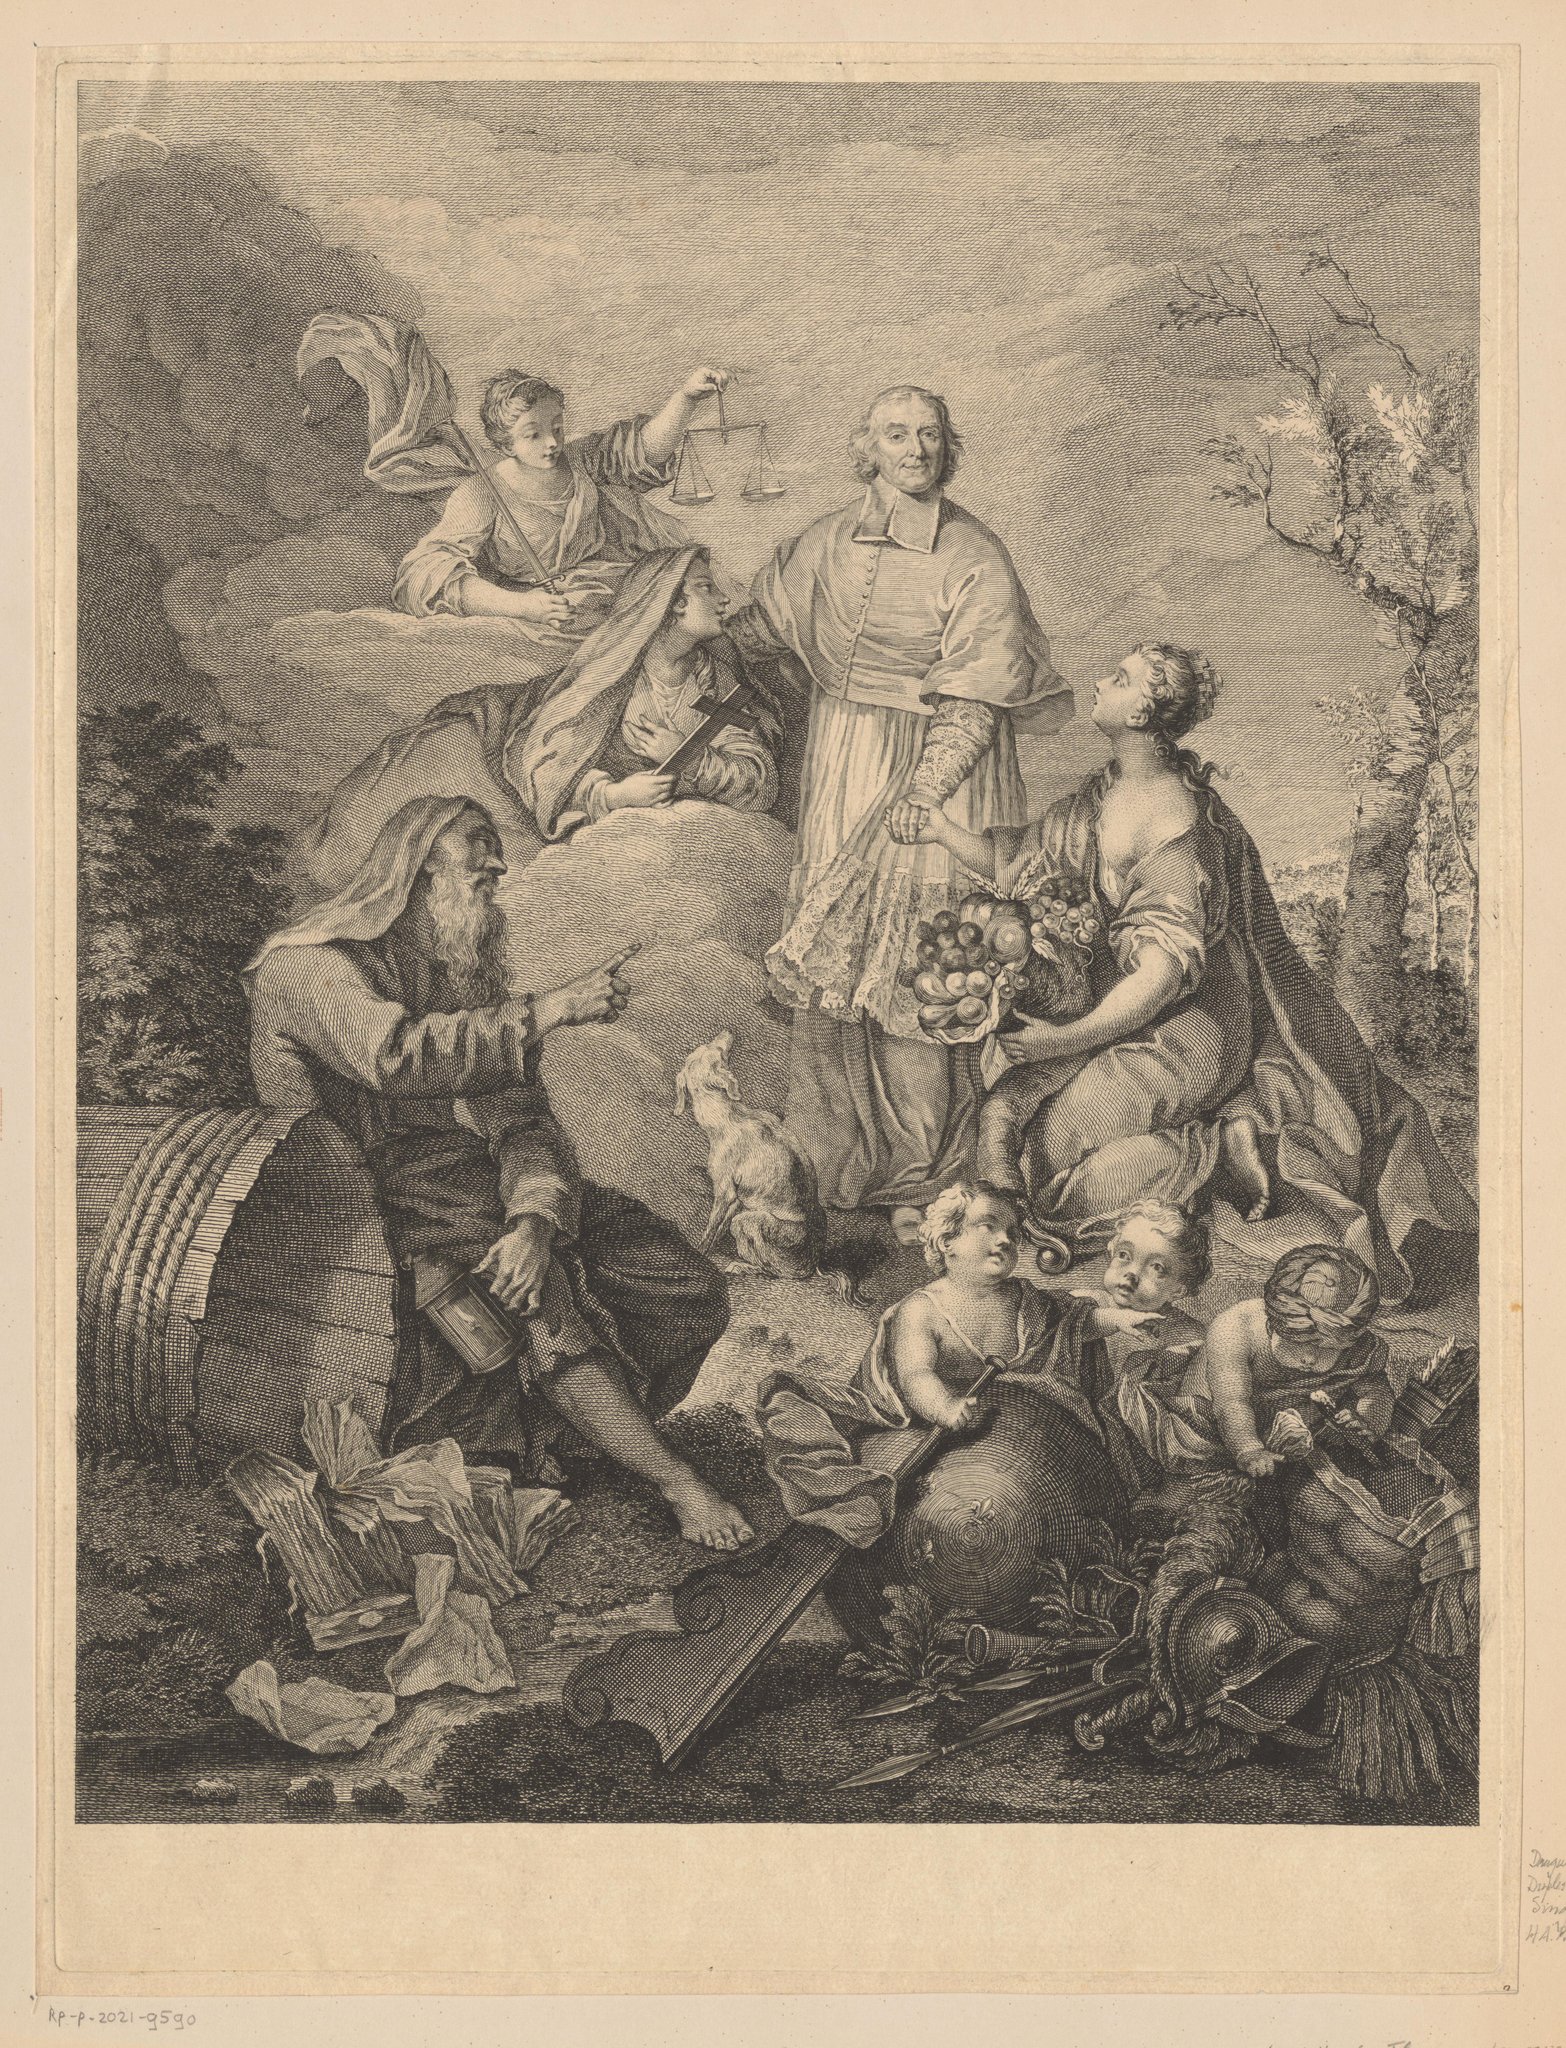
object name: print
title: Allegorisch portret van André Hercule de Fleury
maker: pierre alexandre aveline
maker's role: print maker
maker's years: 1702-1760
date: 1735-1750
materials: paper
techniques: engraving, etching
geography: france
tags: france, city-crown, mural crown, 'cornucopia', horn of plenty, justice, 'justitia'; 'giustitia divina' (ripa) ~ one of the four cardinal virtues, faith, 'fides'; 'fede', 'fede catholica', 'fede christiana', 'fede christiana catholica' (ripa) ~ one of the three theological virtues, cardinal, historical persons, cupids: 'amores', 'amoretti', 'putti', (story of) diogenes, the philosopher, dog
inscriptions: collector's mark: Lugt 240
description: Landschap met linksonder Diogenes, zittend bij een ton, die naar Fleury wijst. Rechtsonder drie putti bij een wereldbol, wapens en een harnas. Een vrouw met Hoorn des Overvloeds en stedenkroon houdt rechts de hand van Fleury vast. Links van Fleury het Geloof (Fides) en boven haar Gerechtigheid (Justitia). Voor Fleury zit een hond.